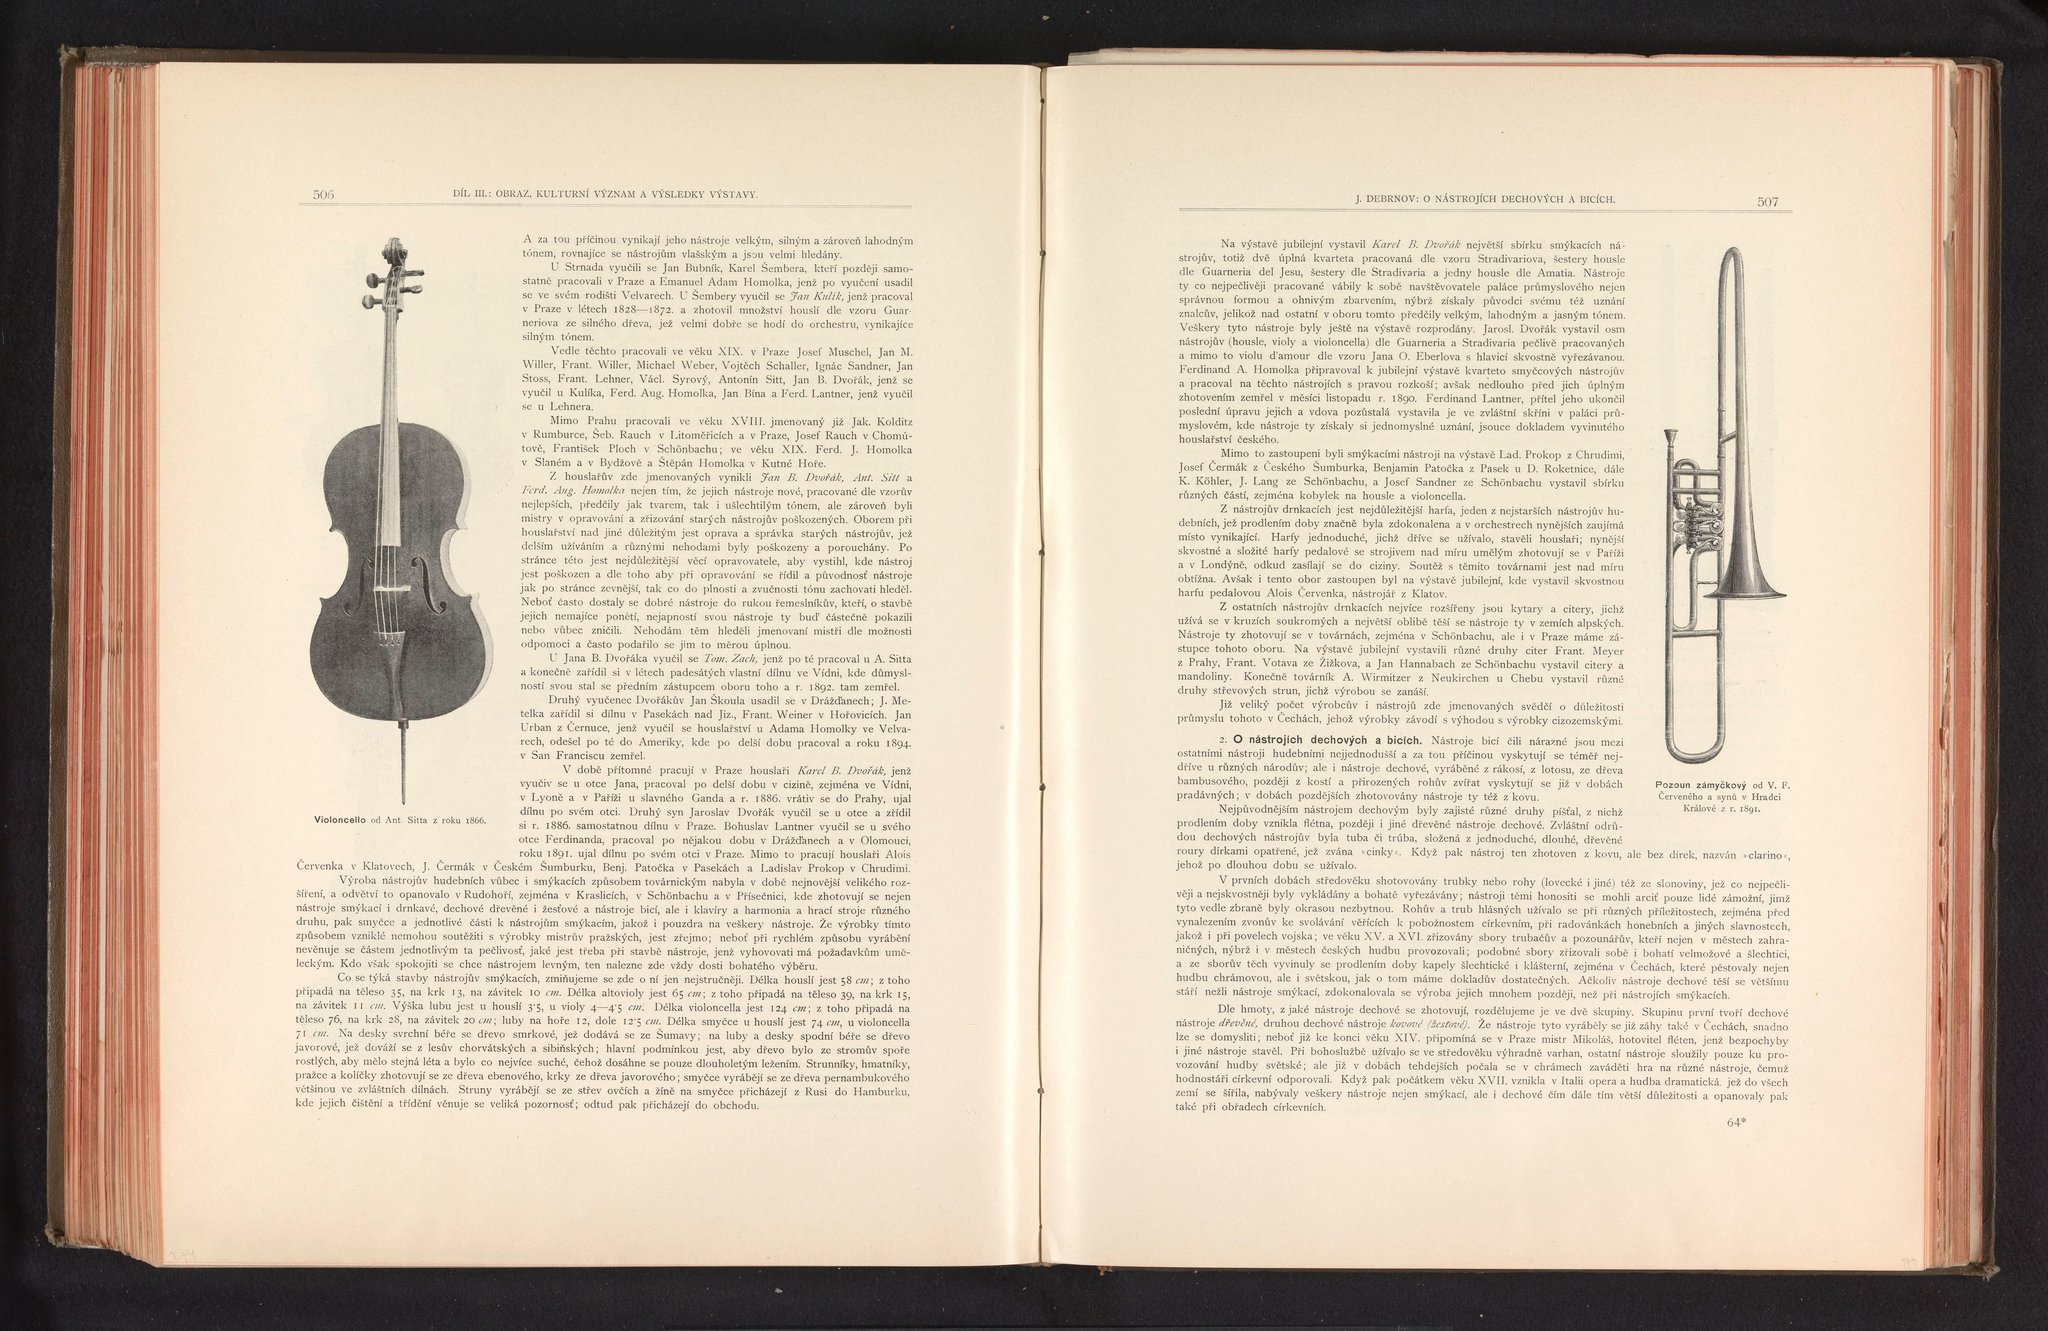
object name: photomechanical print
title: Klarinet, hoboj a flétna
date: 1891-1895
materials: paper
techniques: autotype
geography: prague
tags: clarinet, bassoon, oboe, shawm, flute, aulos, tibia